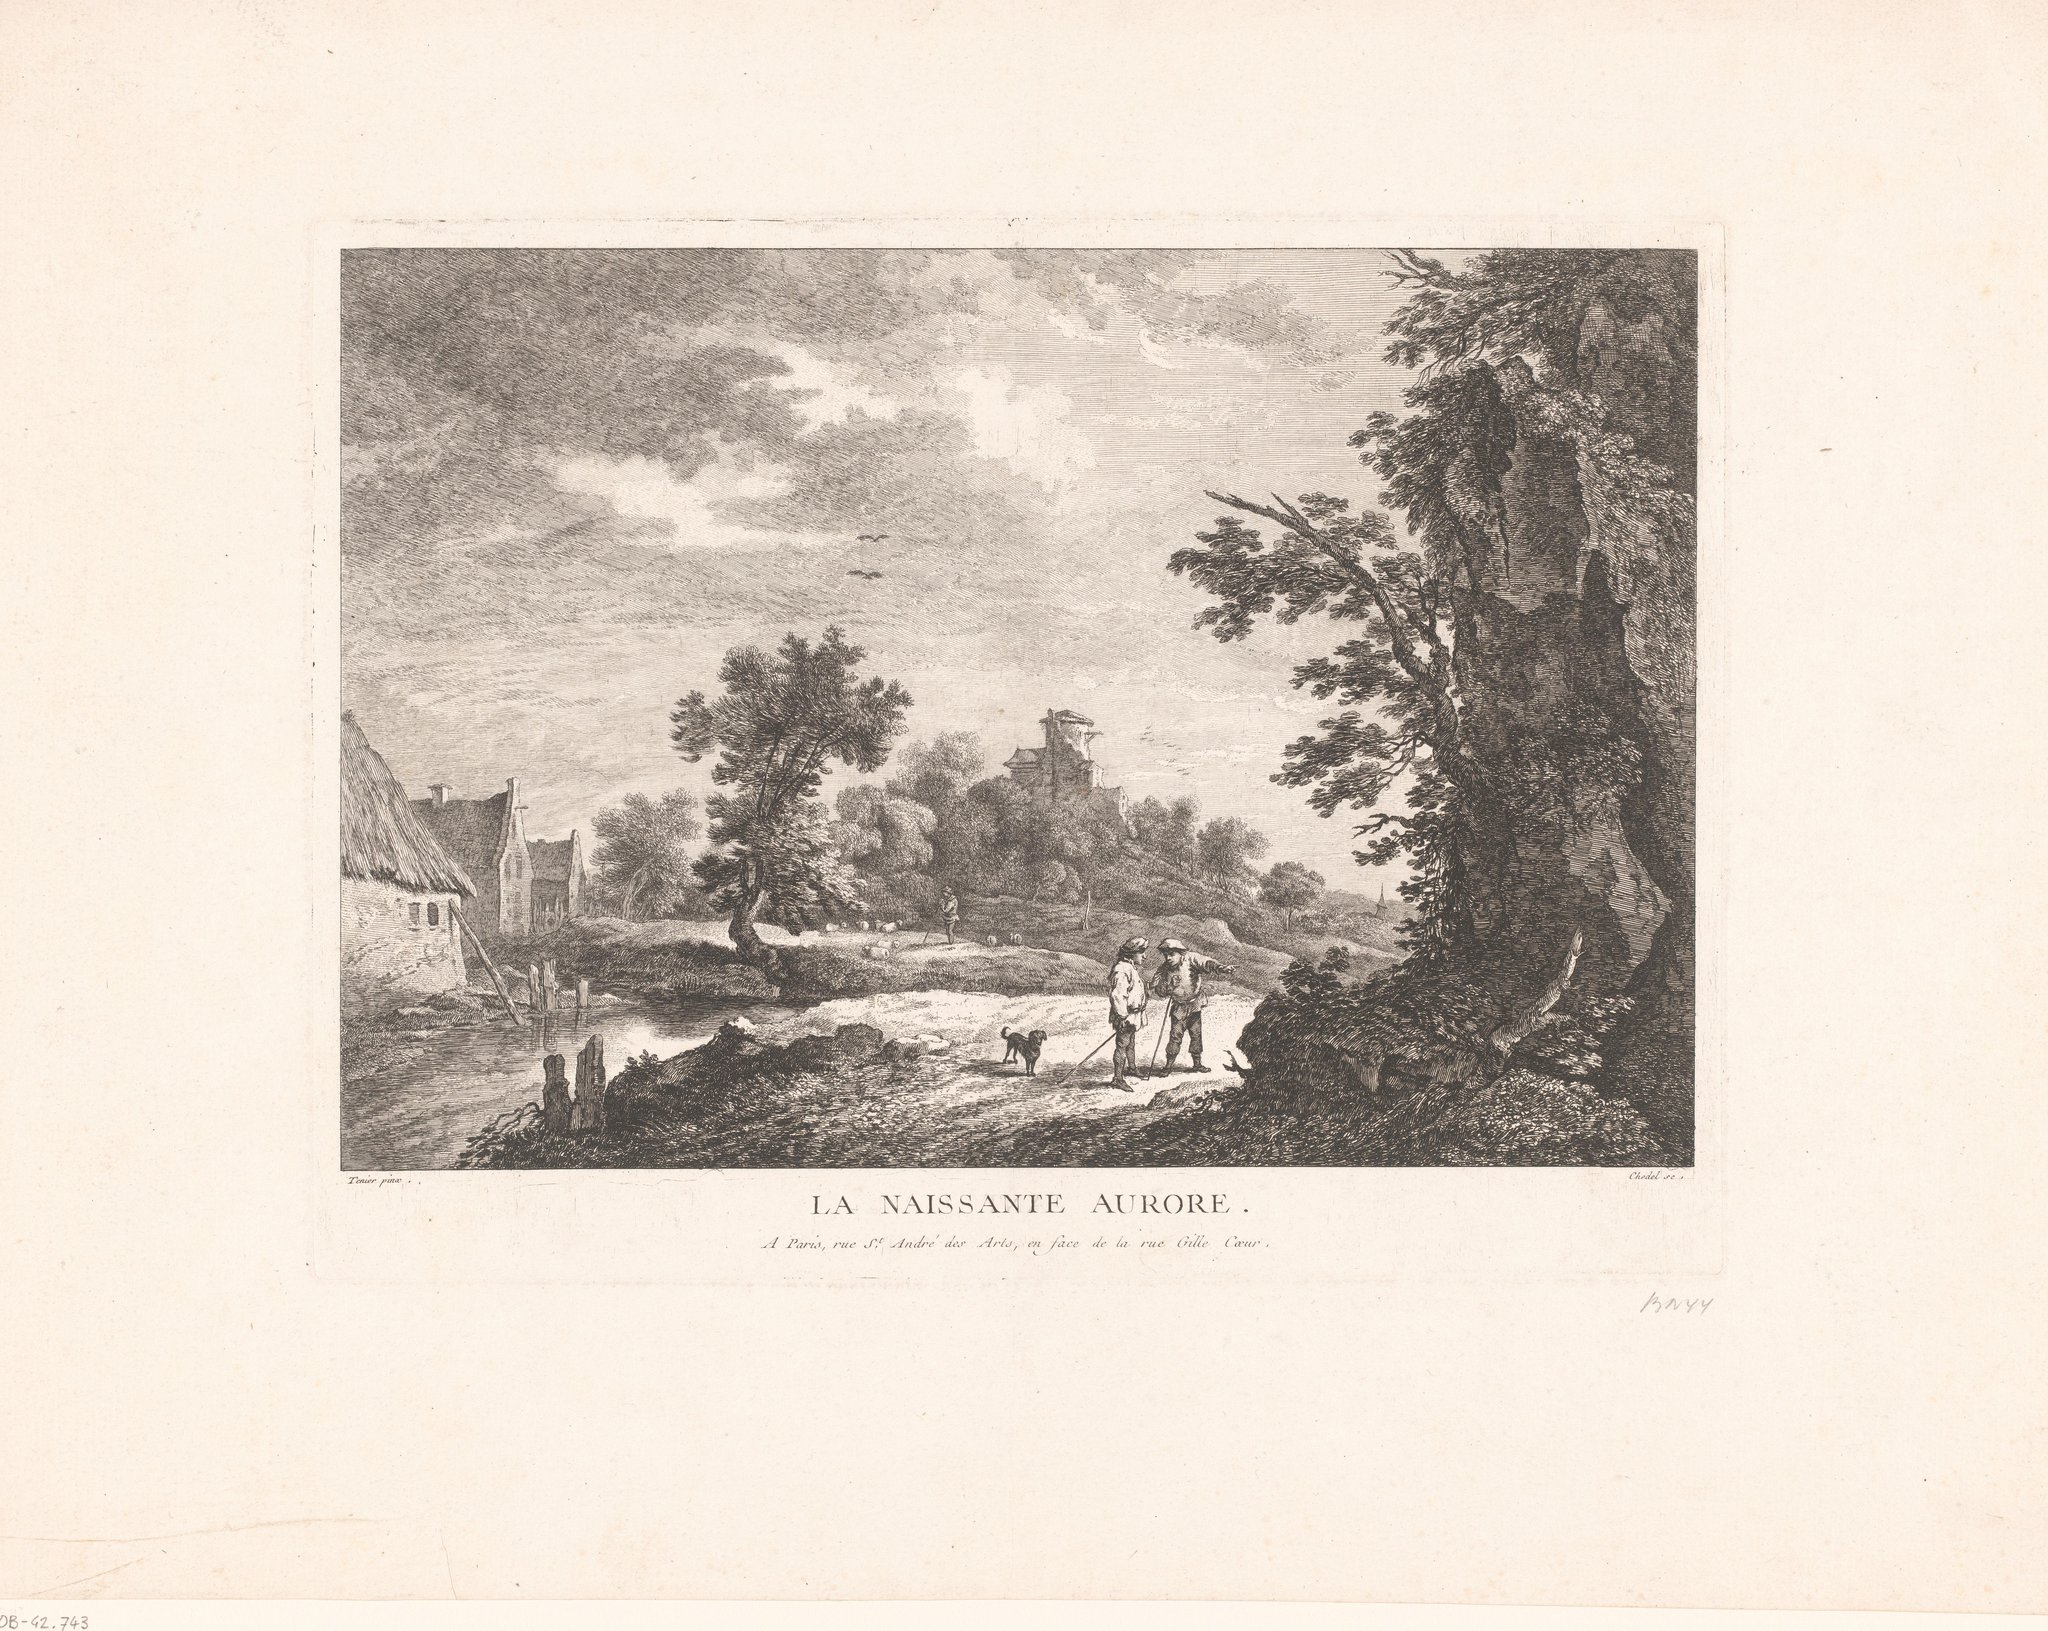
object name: print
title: La Naissante Aurore.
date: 1753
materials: paper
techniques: etching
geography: paris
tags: landscapes (+ landscape with figures, staffage), dog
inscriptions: collector's mark: Lugt 240